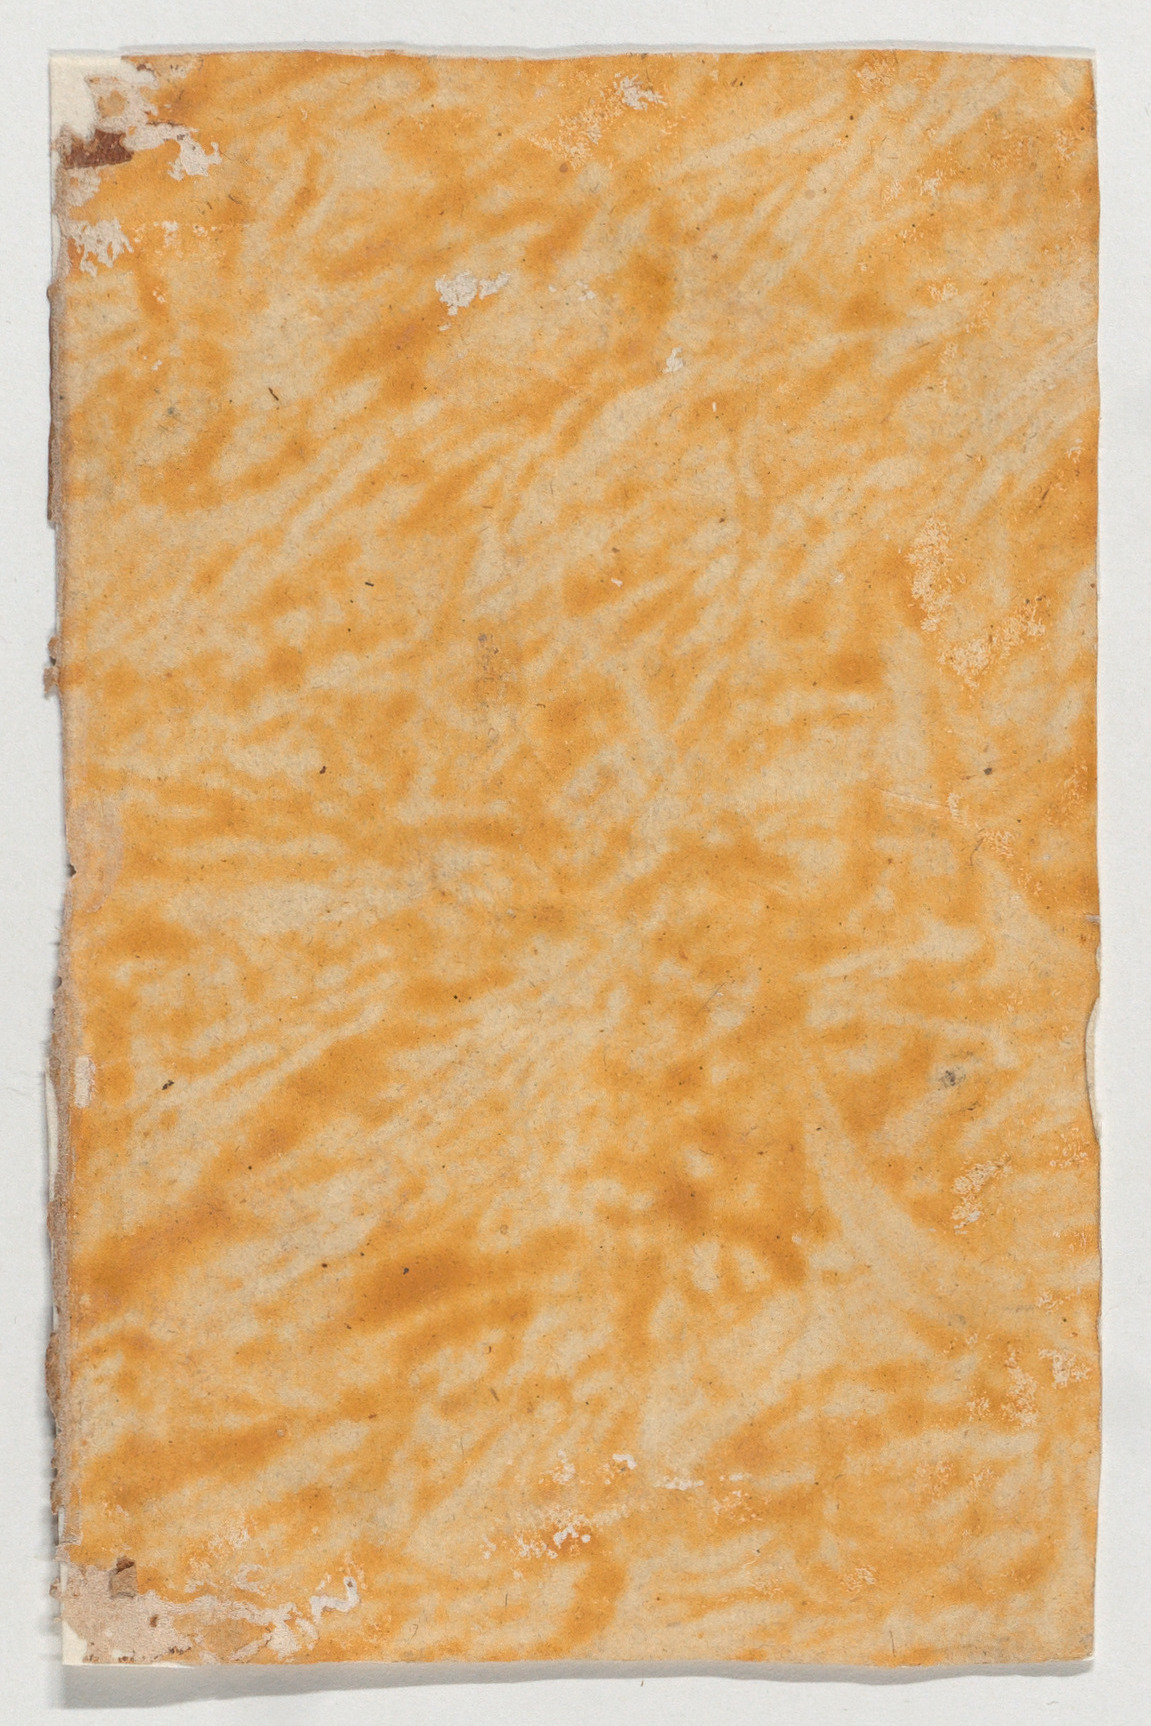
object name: print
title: Yellow paste paper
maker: Anonymous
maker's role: artist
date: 1701-1800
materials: paper, paste